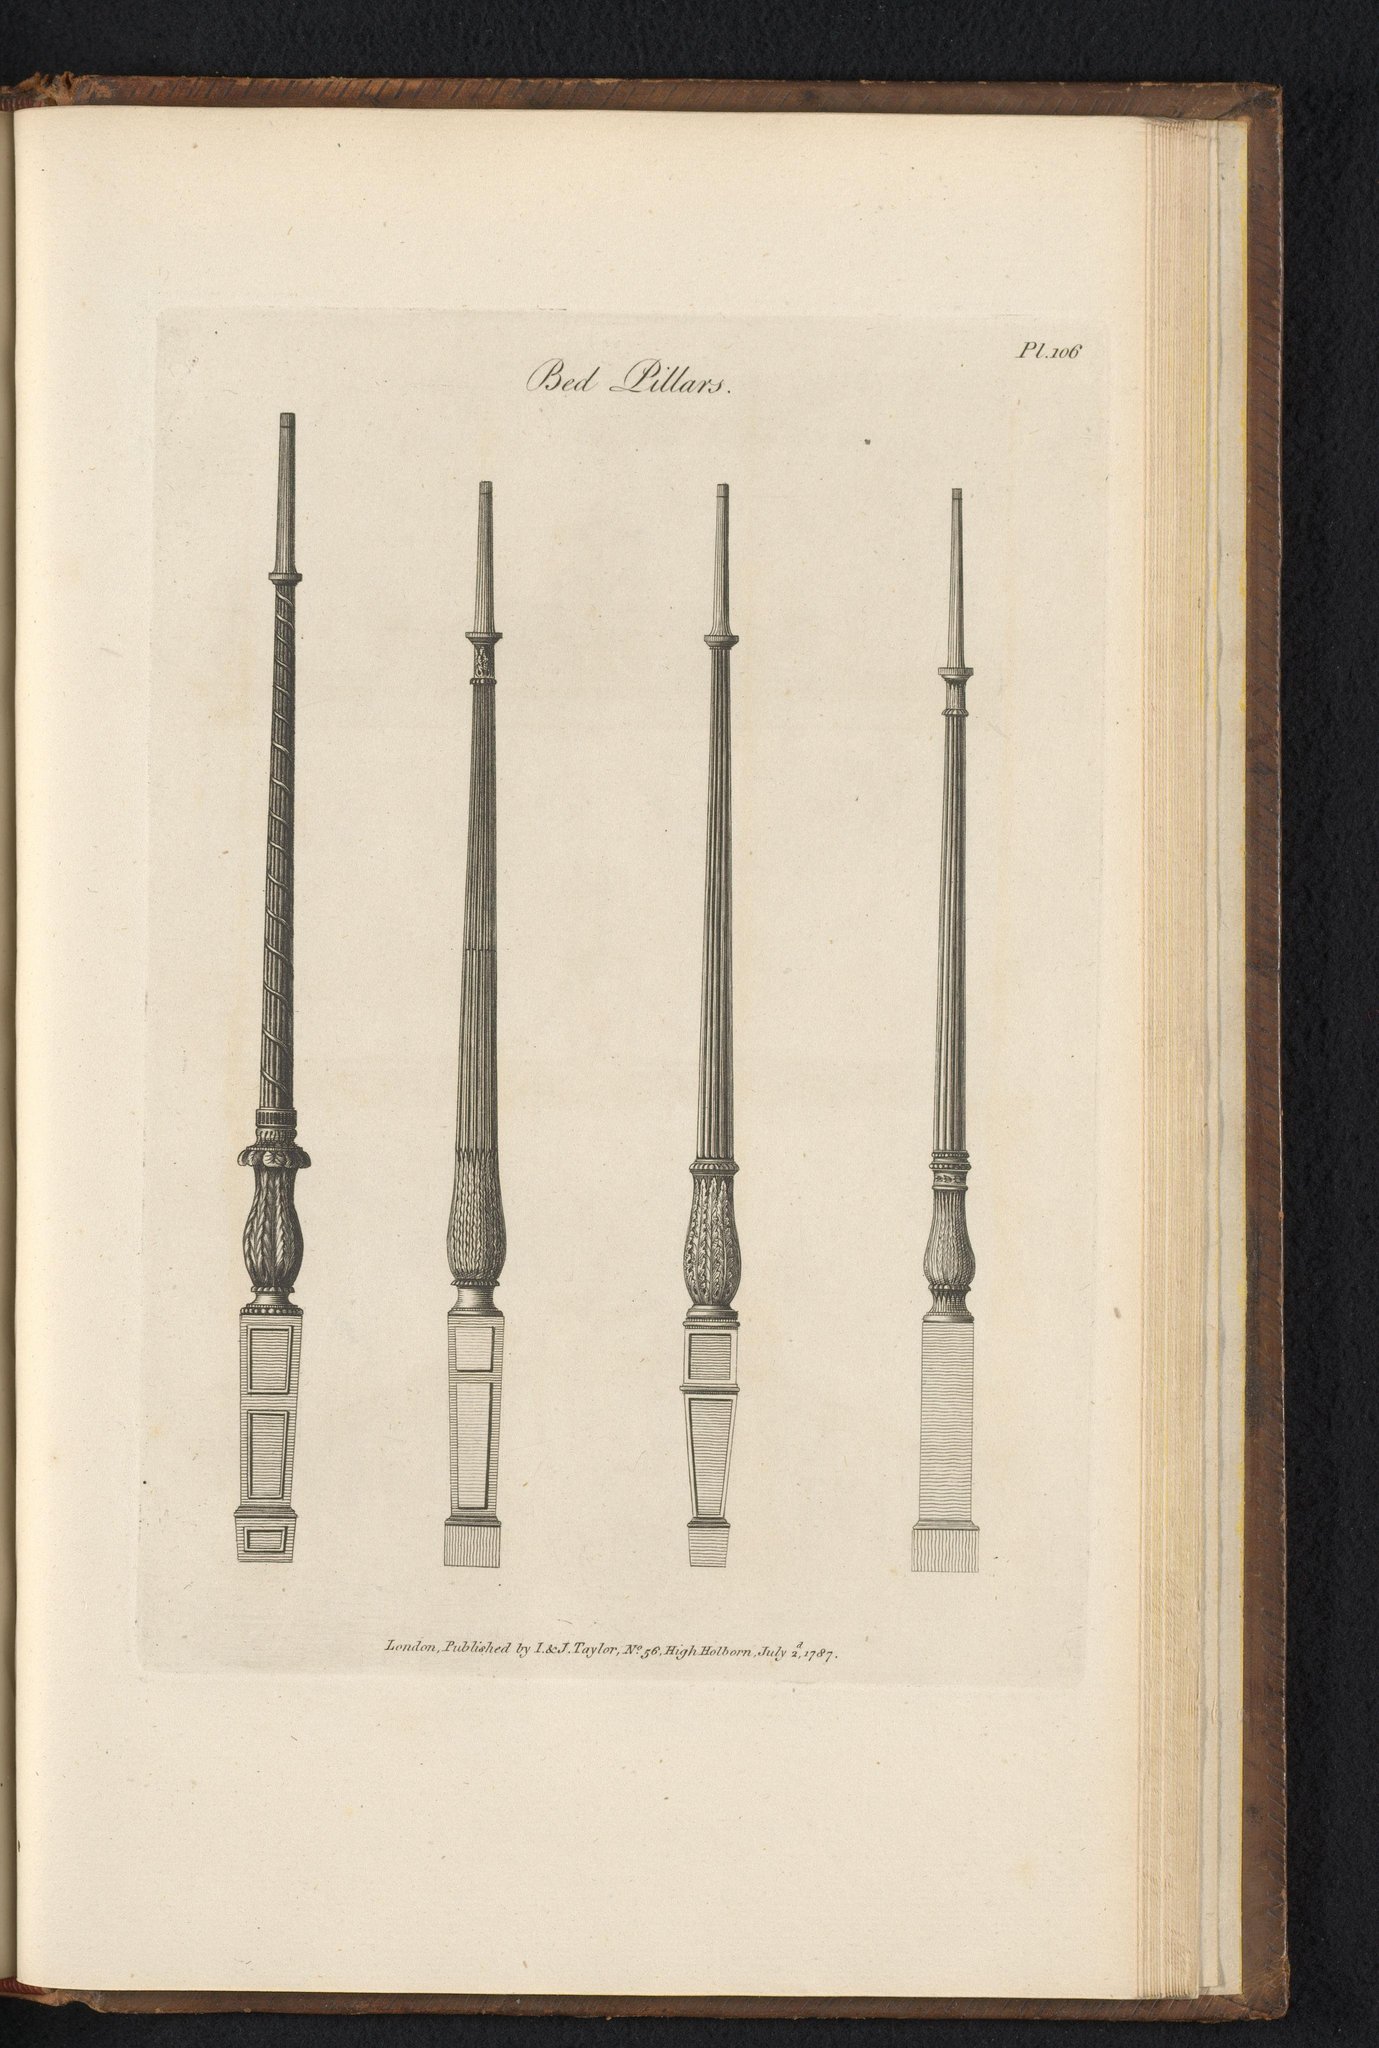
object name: page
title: Vier bedstijlen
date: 1787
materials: paper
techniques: engraving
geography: holborn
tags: tent-camp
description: Genummerd: Pl. 106. Prent maakt deel uit van een boek.